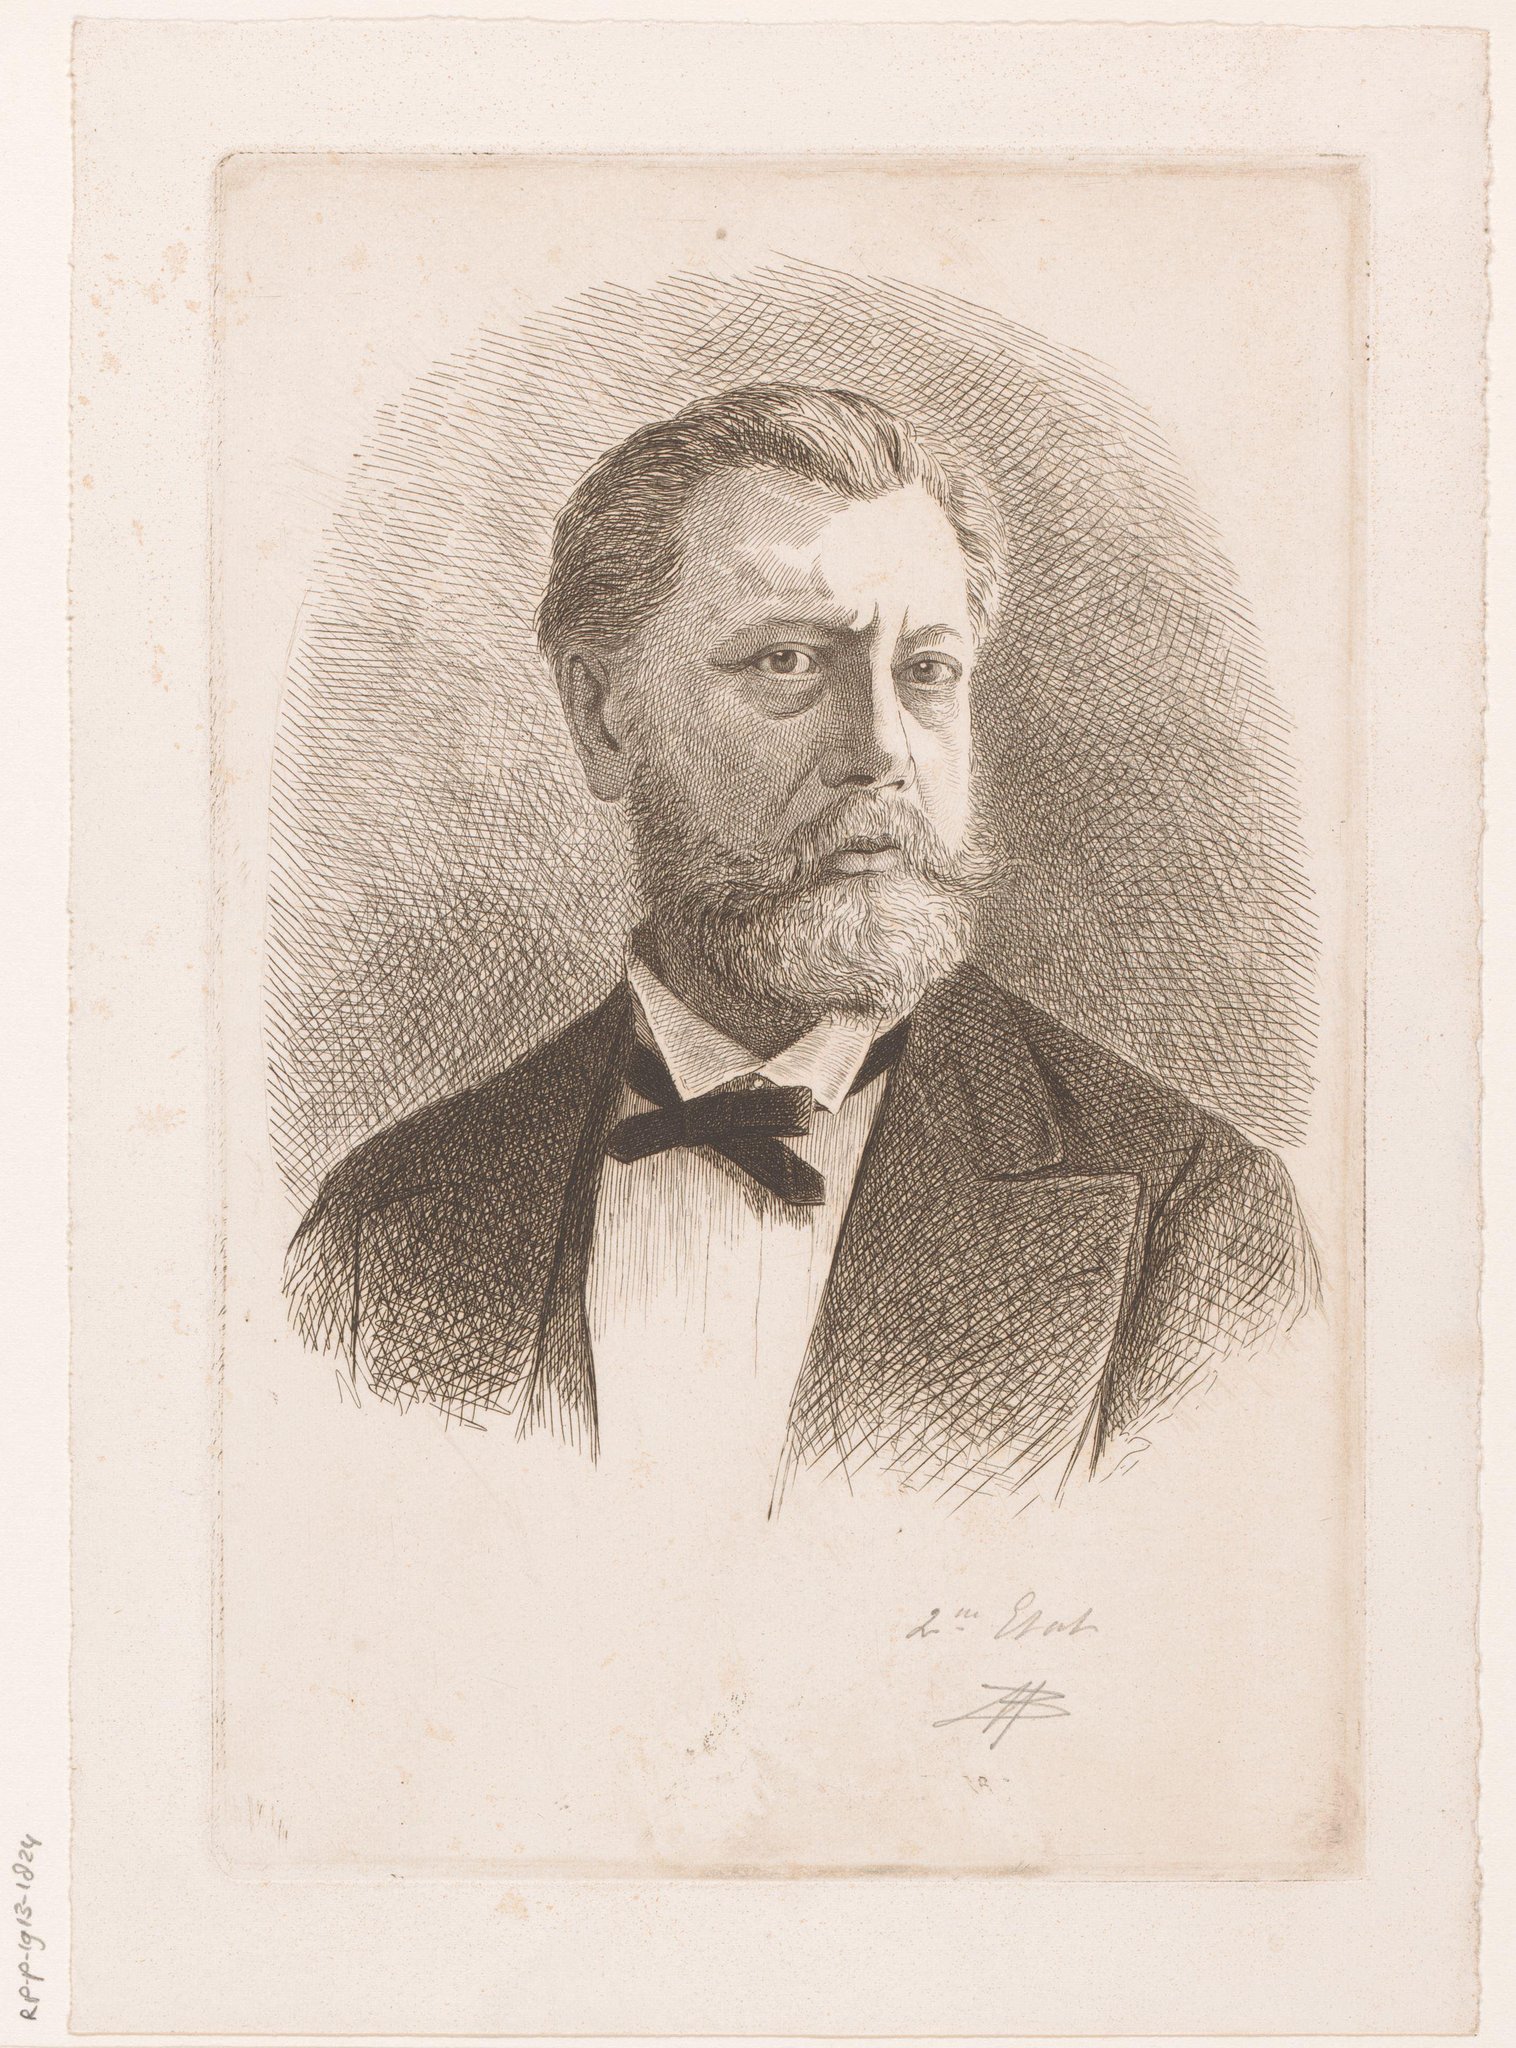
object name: print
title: Portret van Adrien Joseph Verhoeven-Ball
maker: jean baptiste pierre michiels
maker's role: print maker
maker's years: 1821-1890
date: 1882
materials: paper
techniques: etching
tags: antwerp, print maker, draughtsman, adrien joseph verhoeven-ball, adult man, historical persons, portrait, self-portrait of artist, beard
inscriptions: collector's mark: Lugt 2228, inscription: ‘2m Etat’